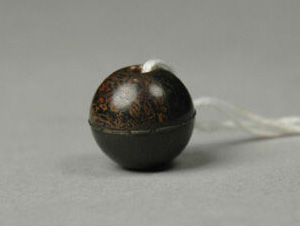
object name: ojime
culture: japanese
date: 1801-1900